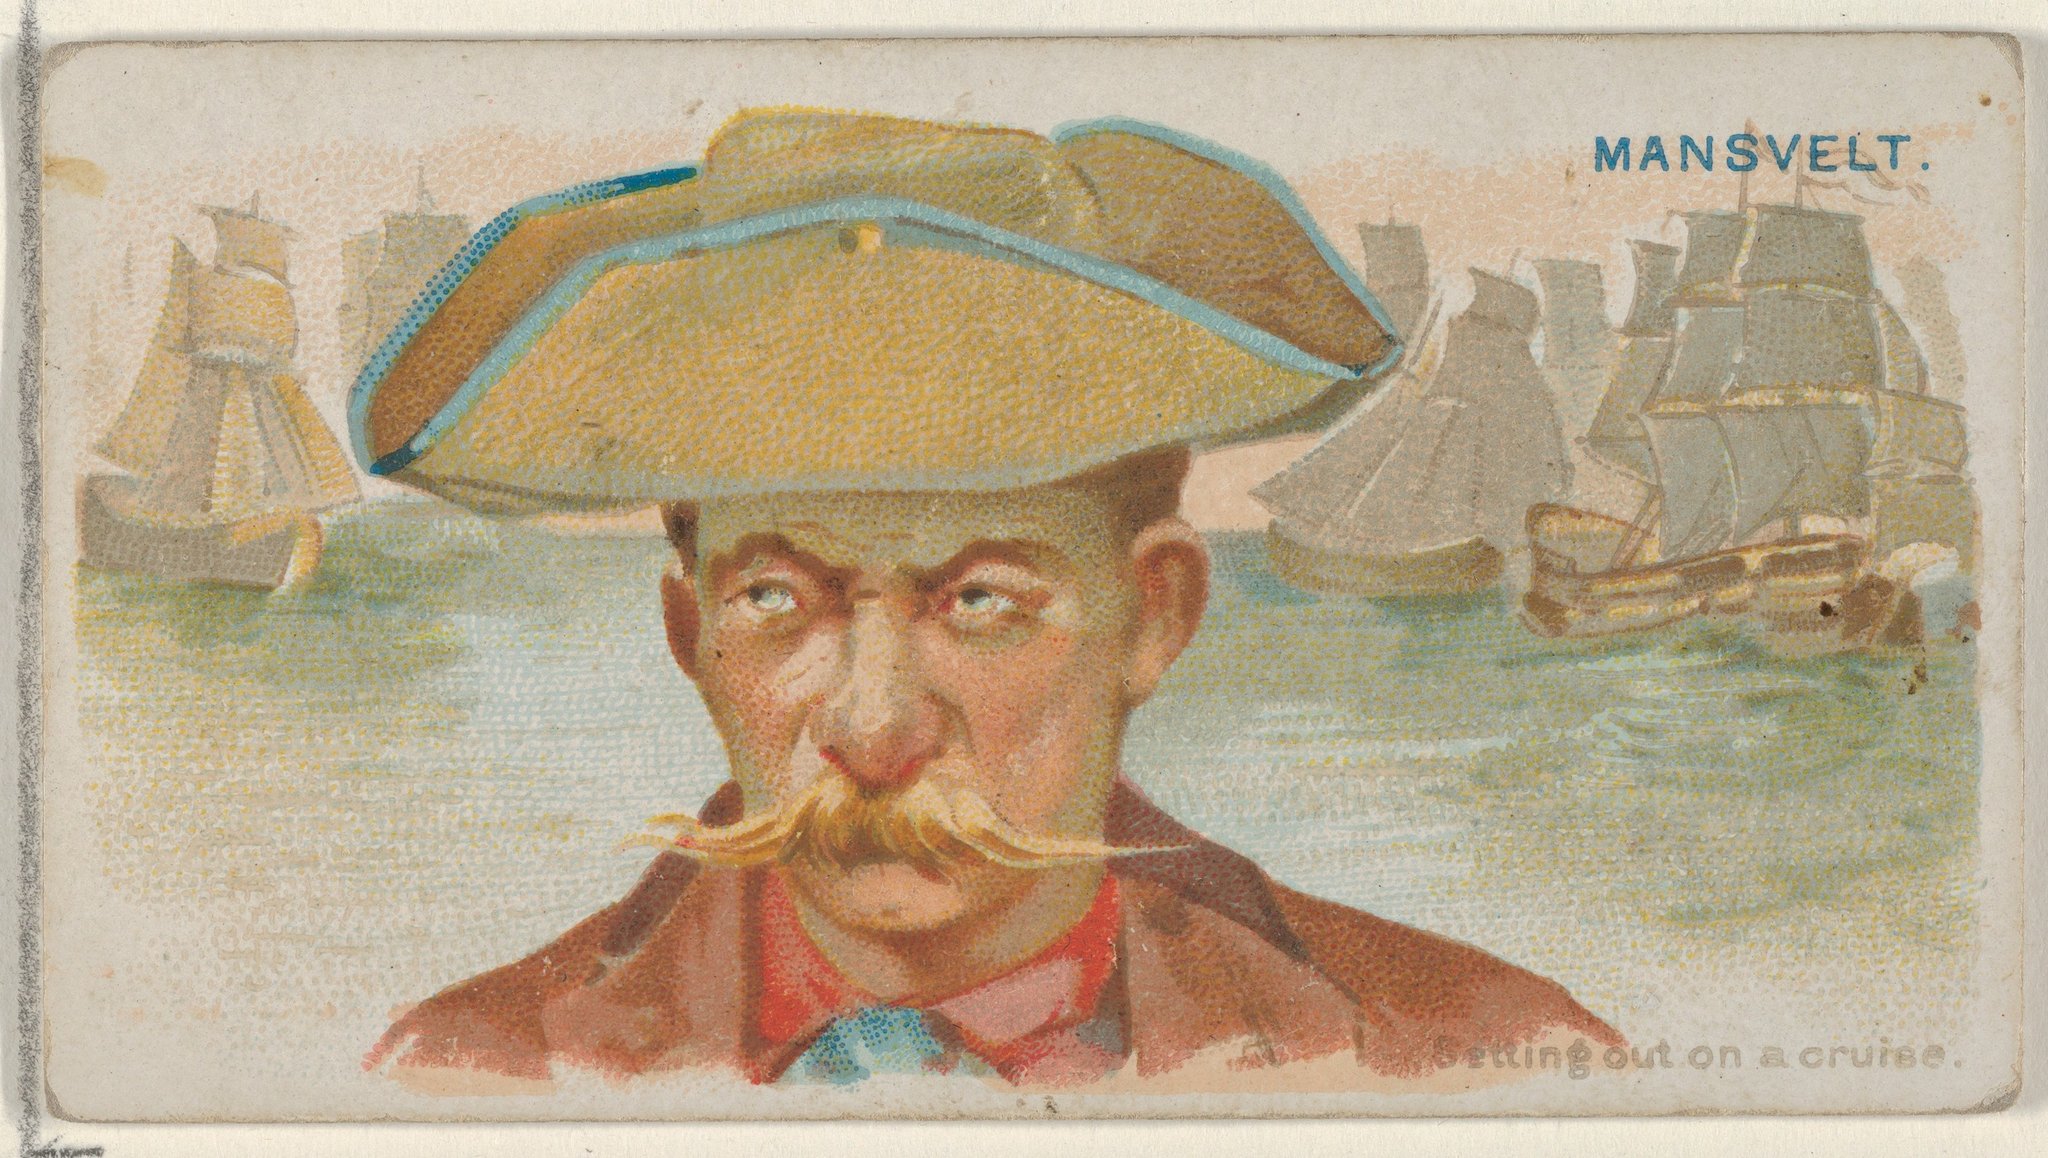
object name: print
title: Edward Mansvelt, Setting Out on a Cruise, from the Pirates of the Spanish Main series (N19) for Allen & Ginter Cigarettes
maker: allen & ginter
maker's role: publisher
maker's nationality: american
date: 1888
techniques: color lithograph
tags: men,boats